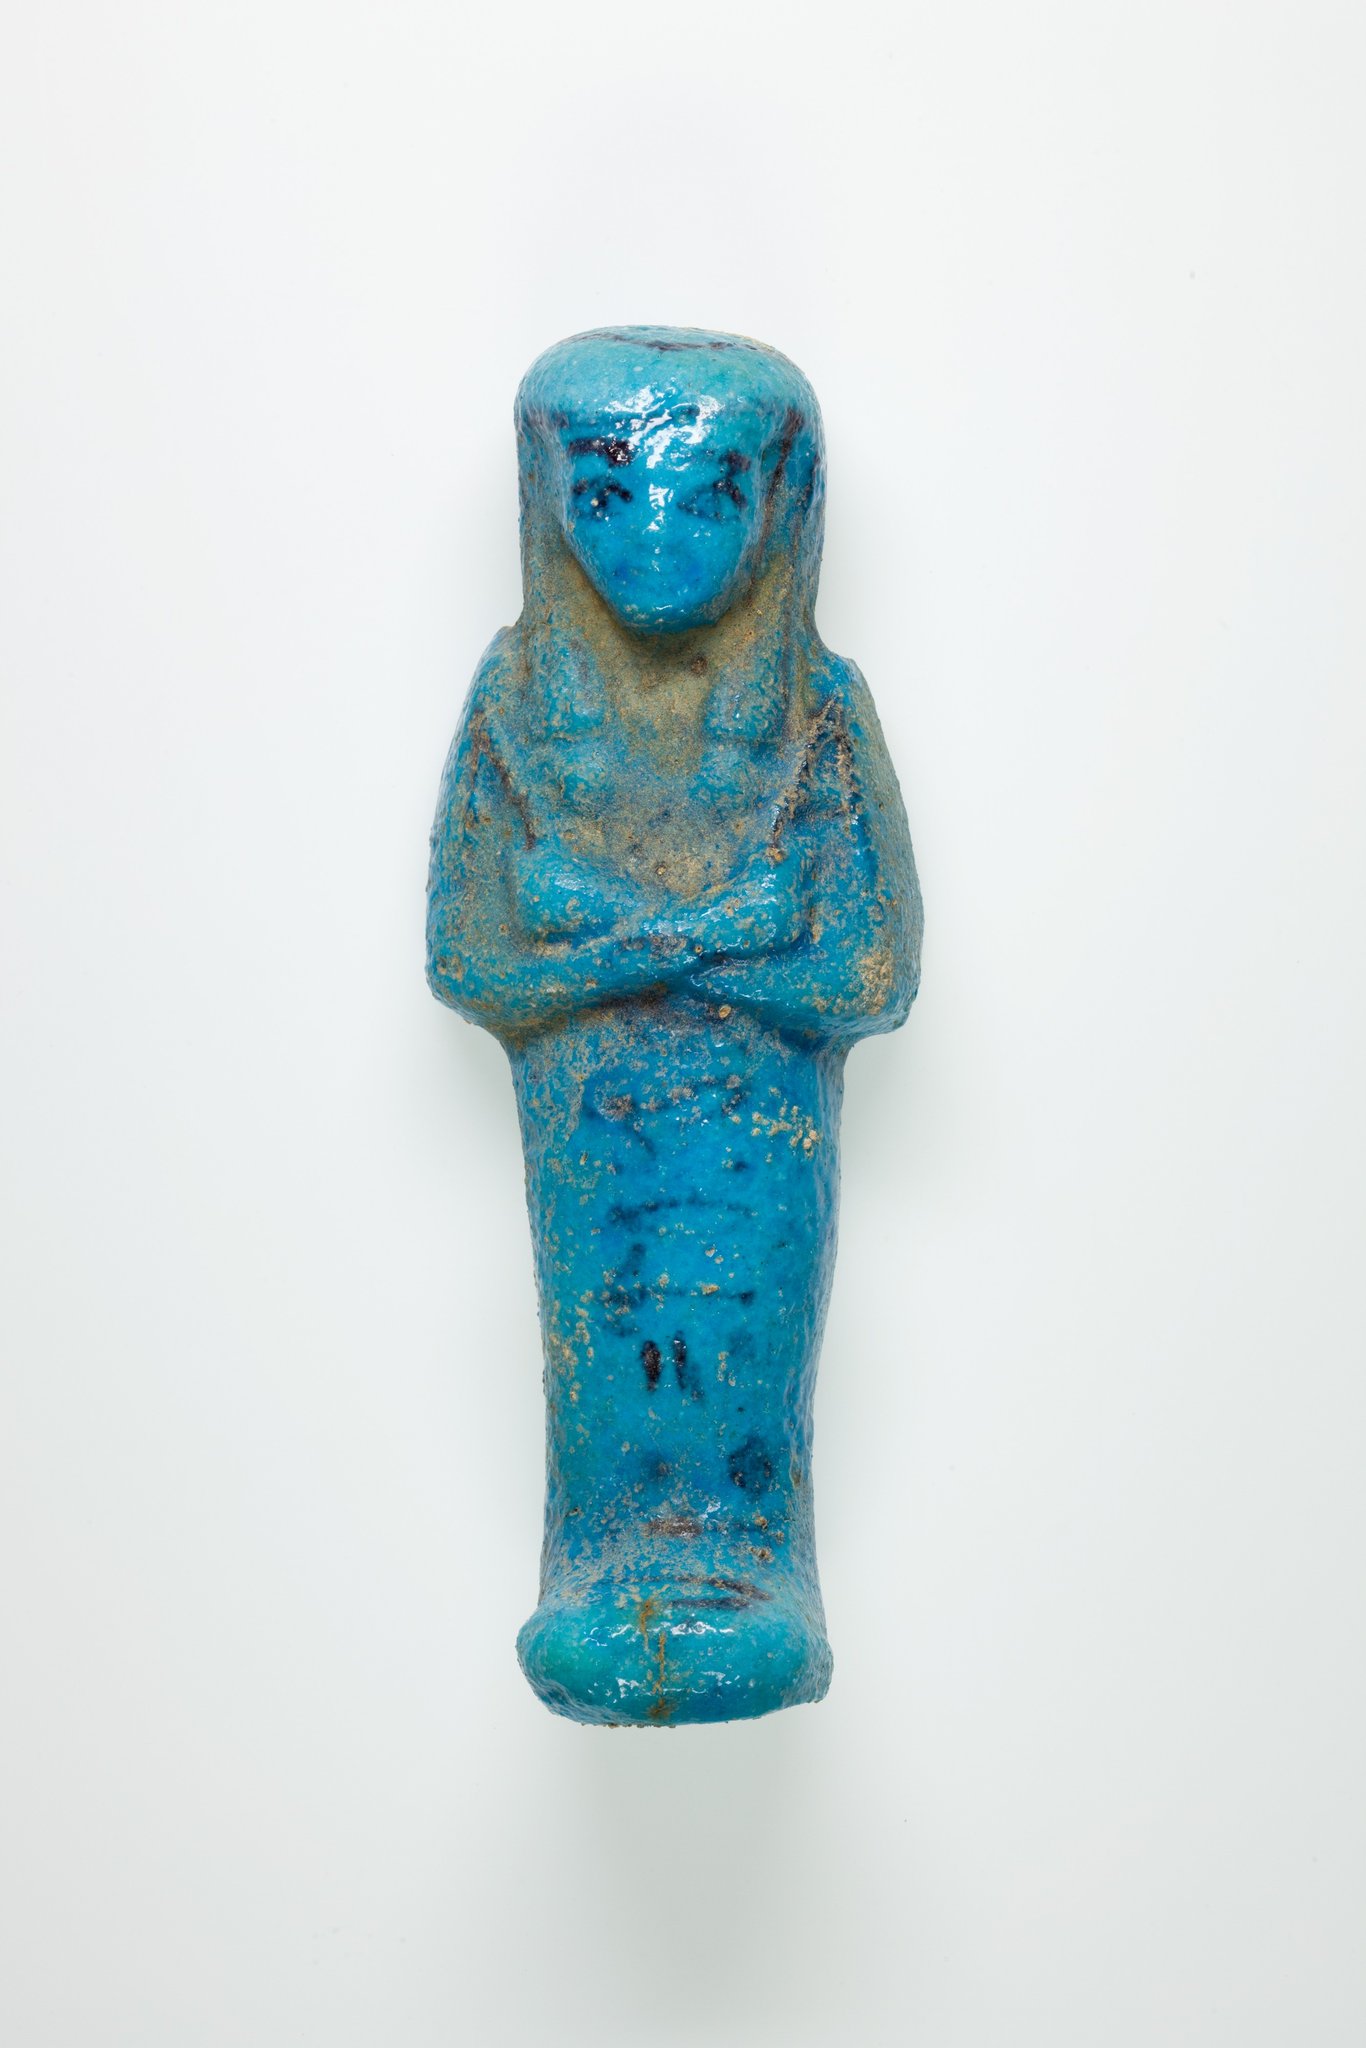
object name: worker shabti, henettawy c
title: Worker Shabti of Henettawy (C), Daughter of Isetemkheb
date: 990-970 BCE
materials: faience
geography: egypt